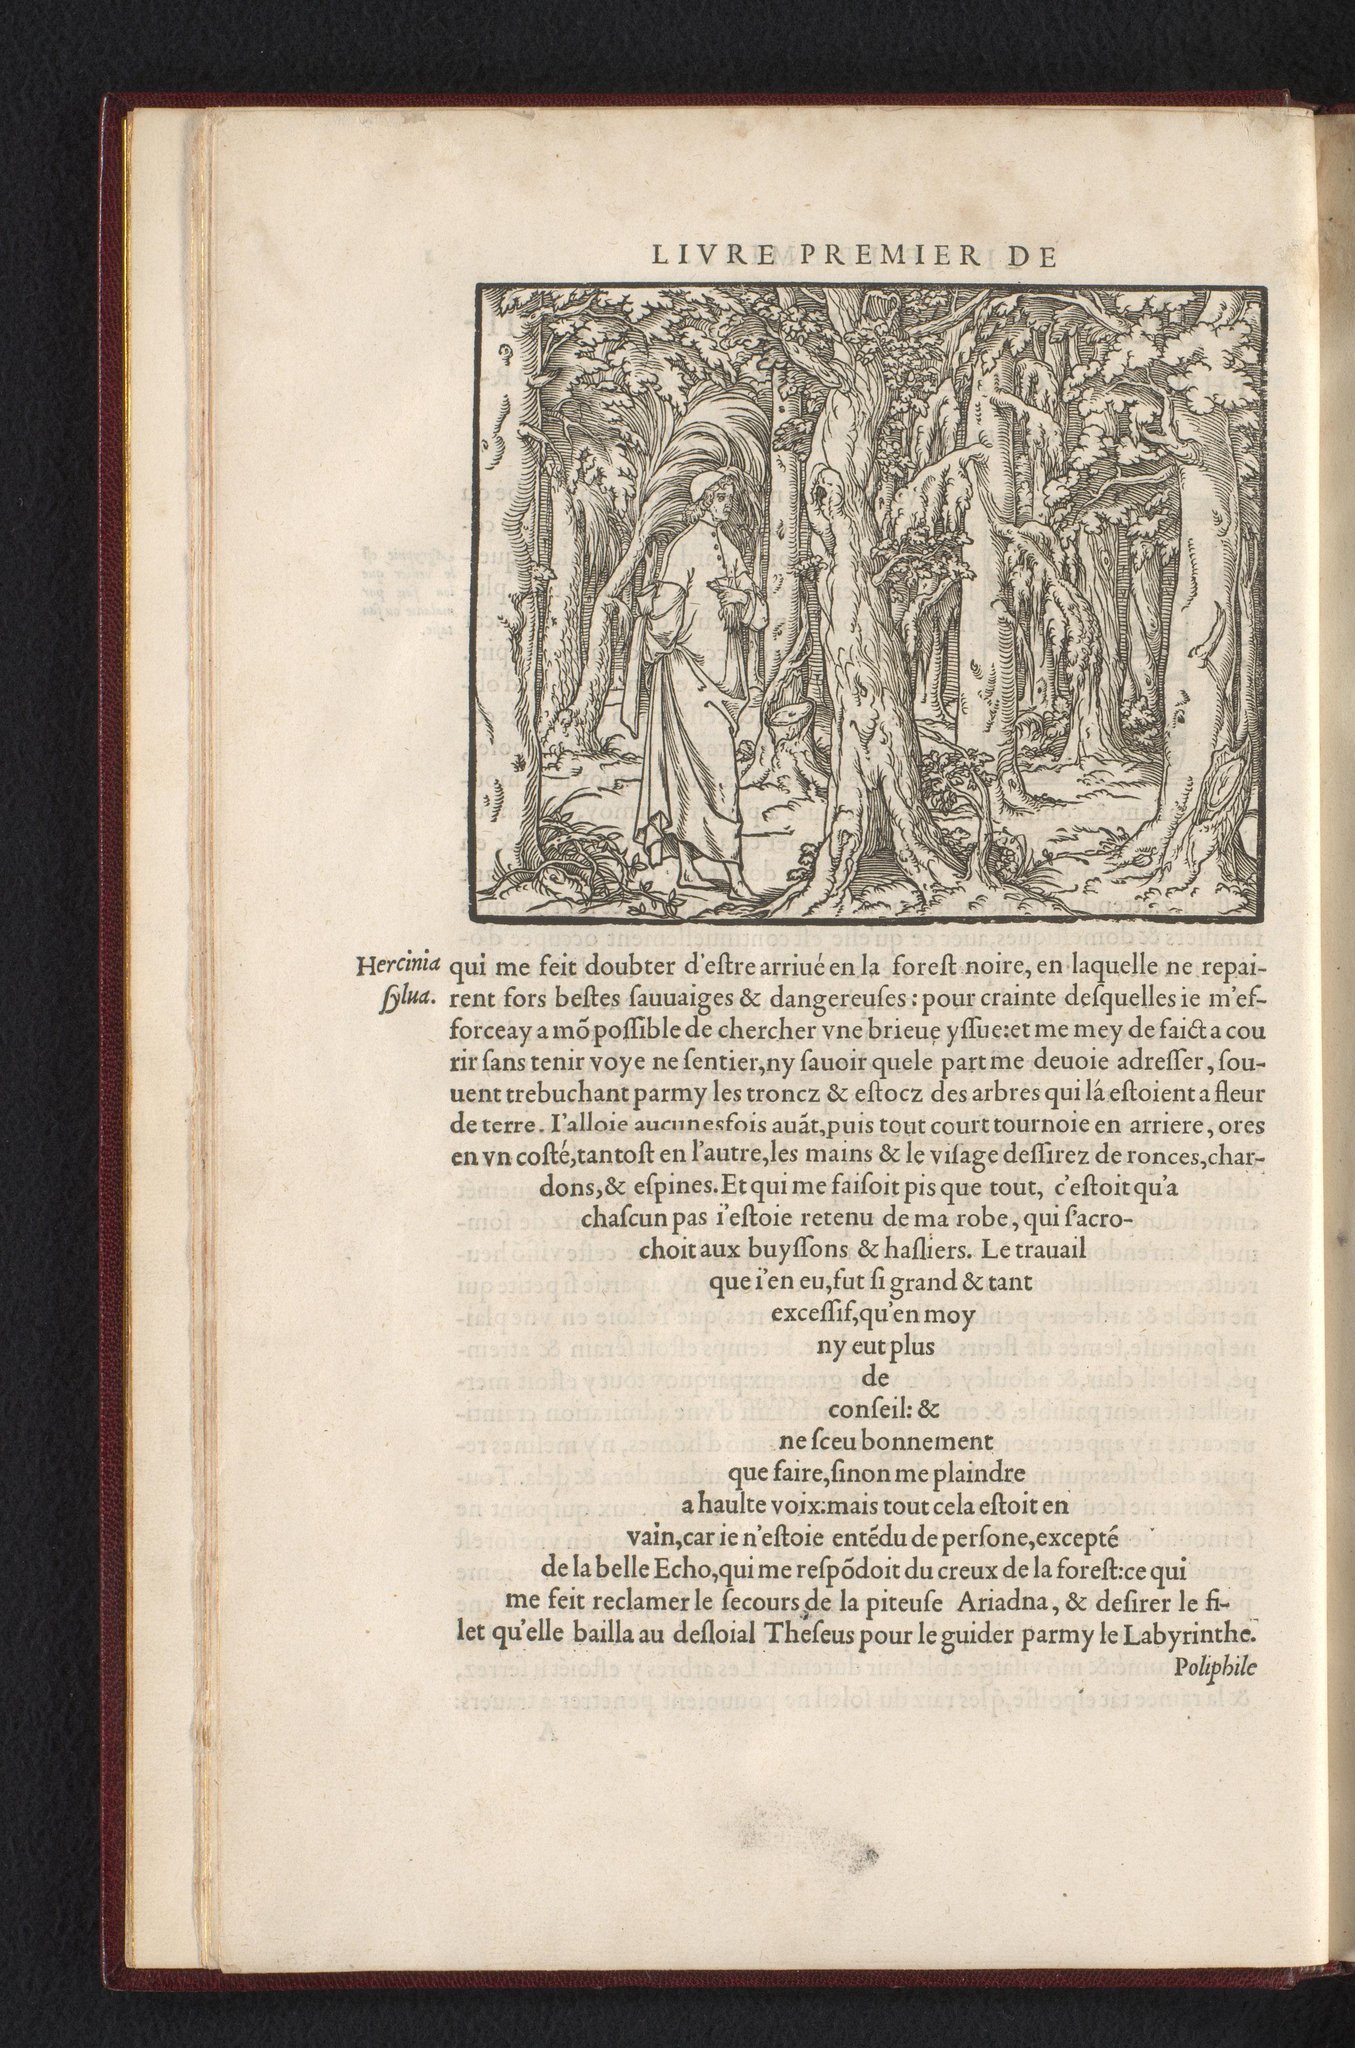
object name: book illustration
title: Poliphilo loopt een dichtbegroeid bos in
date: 1546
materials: paper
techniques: letterpress printing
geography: paris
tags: (scenes from) specific works of literature: colonna, hypnerotomachia poliphili, forest, wood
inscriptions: collector's mark: Lugt 2166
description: Prent uit: Colonna, Francesco. Hypnerotomachie ou discours du songe de Poliphile, deduisant comme amour le combat a l'occasion de Polia. Parijs: Jacques Kerver, 1546, verso fol. 1.